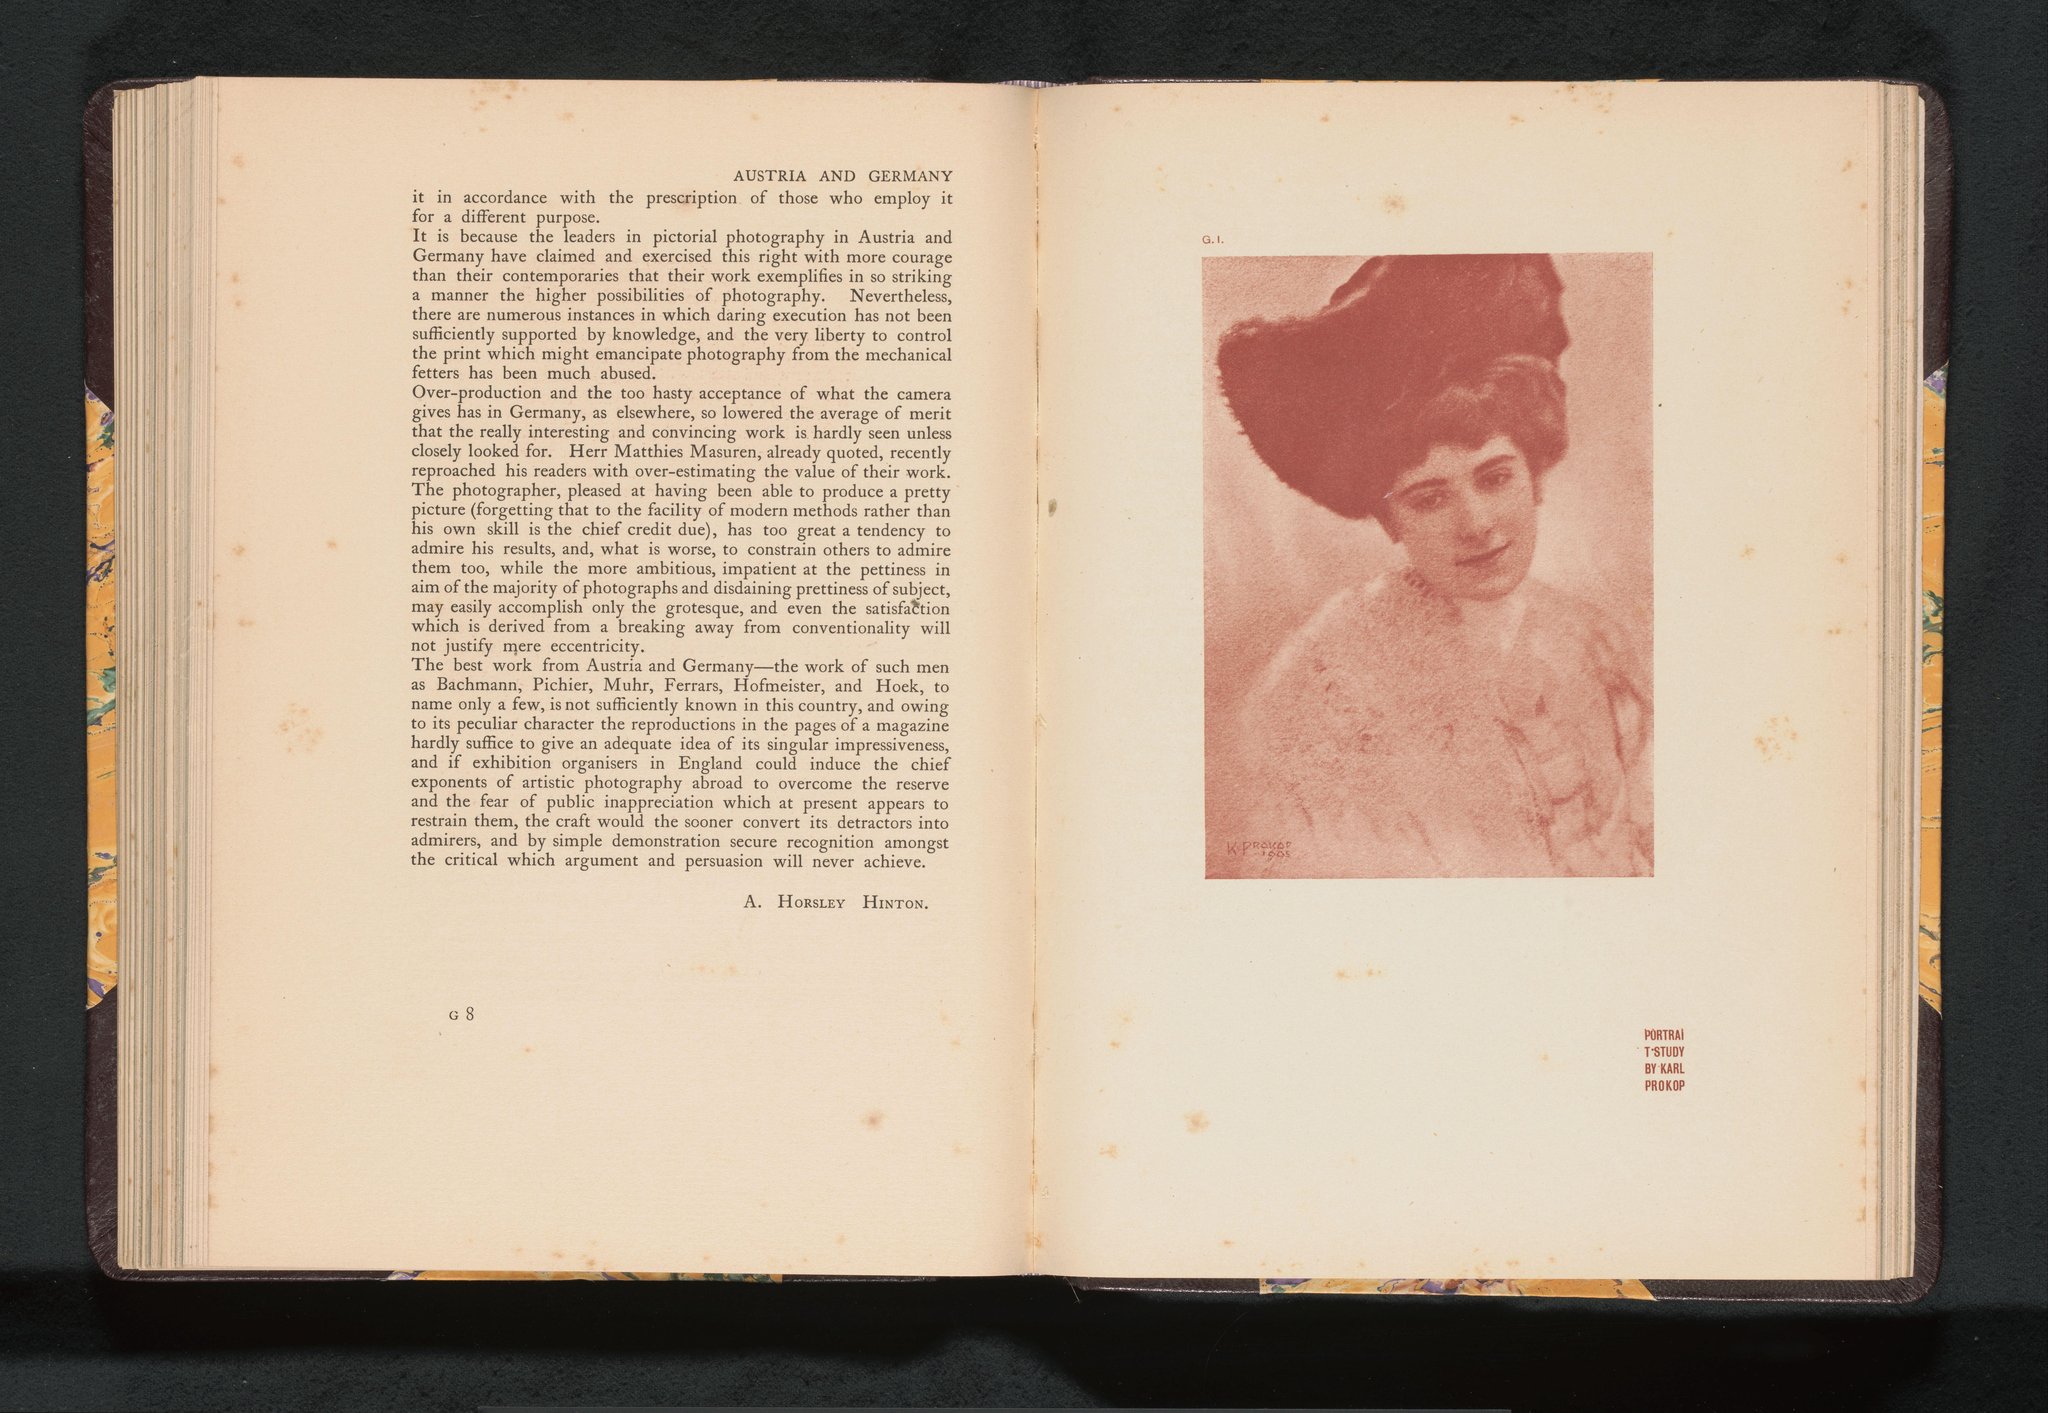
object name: page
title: Portretstudie van een onbekende vrouw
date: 1900-1905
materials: paper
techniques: autotype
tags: historical persons - bb - woman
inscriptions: inscription: ‘G. I.’, inscription: ‘Portrait study b Karl Prokop’